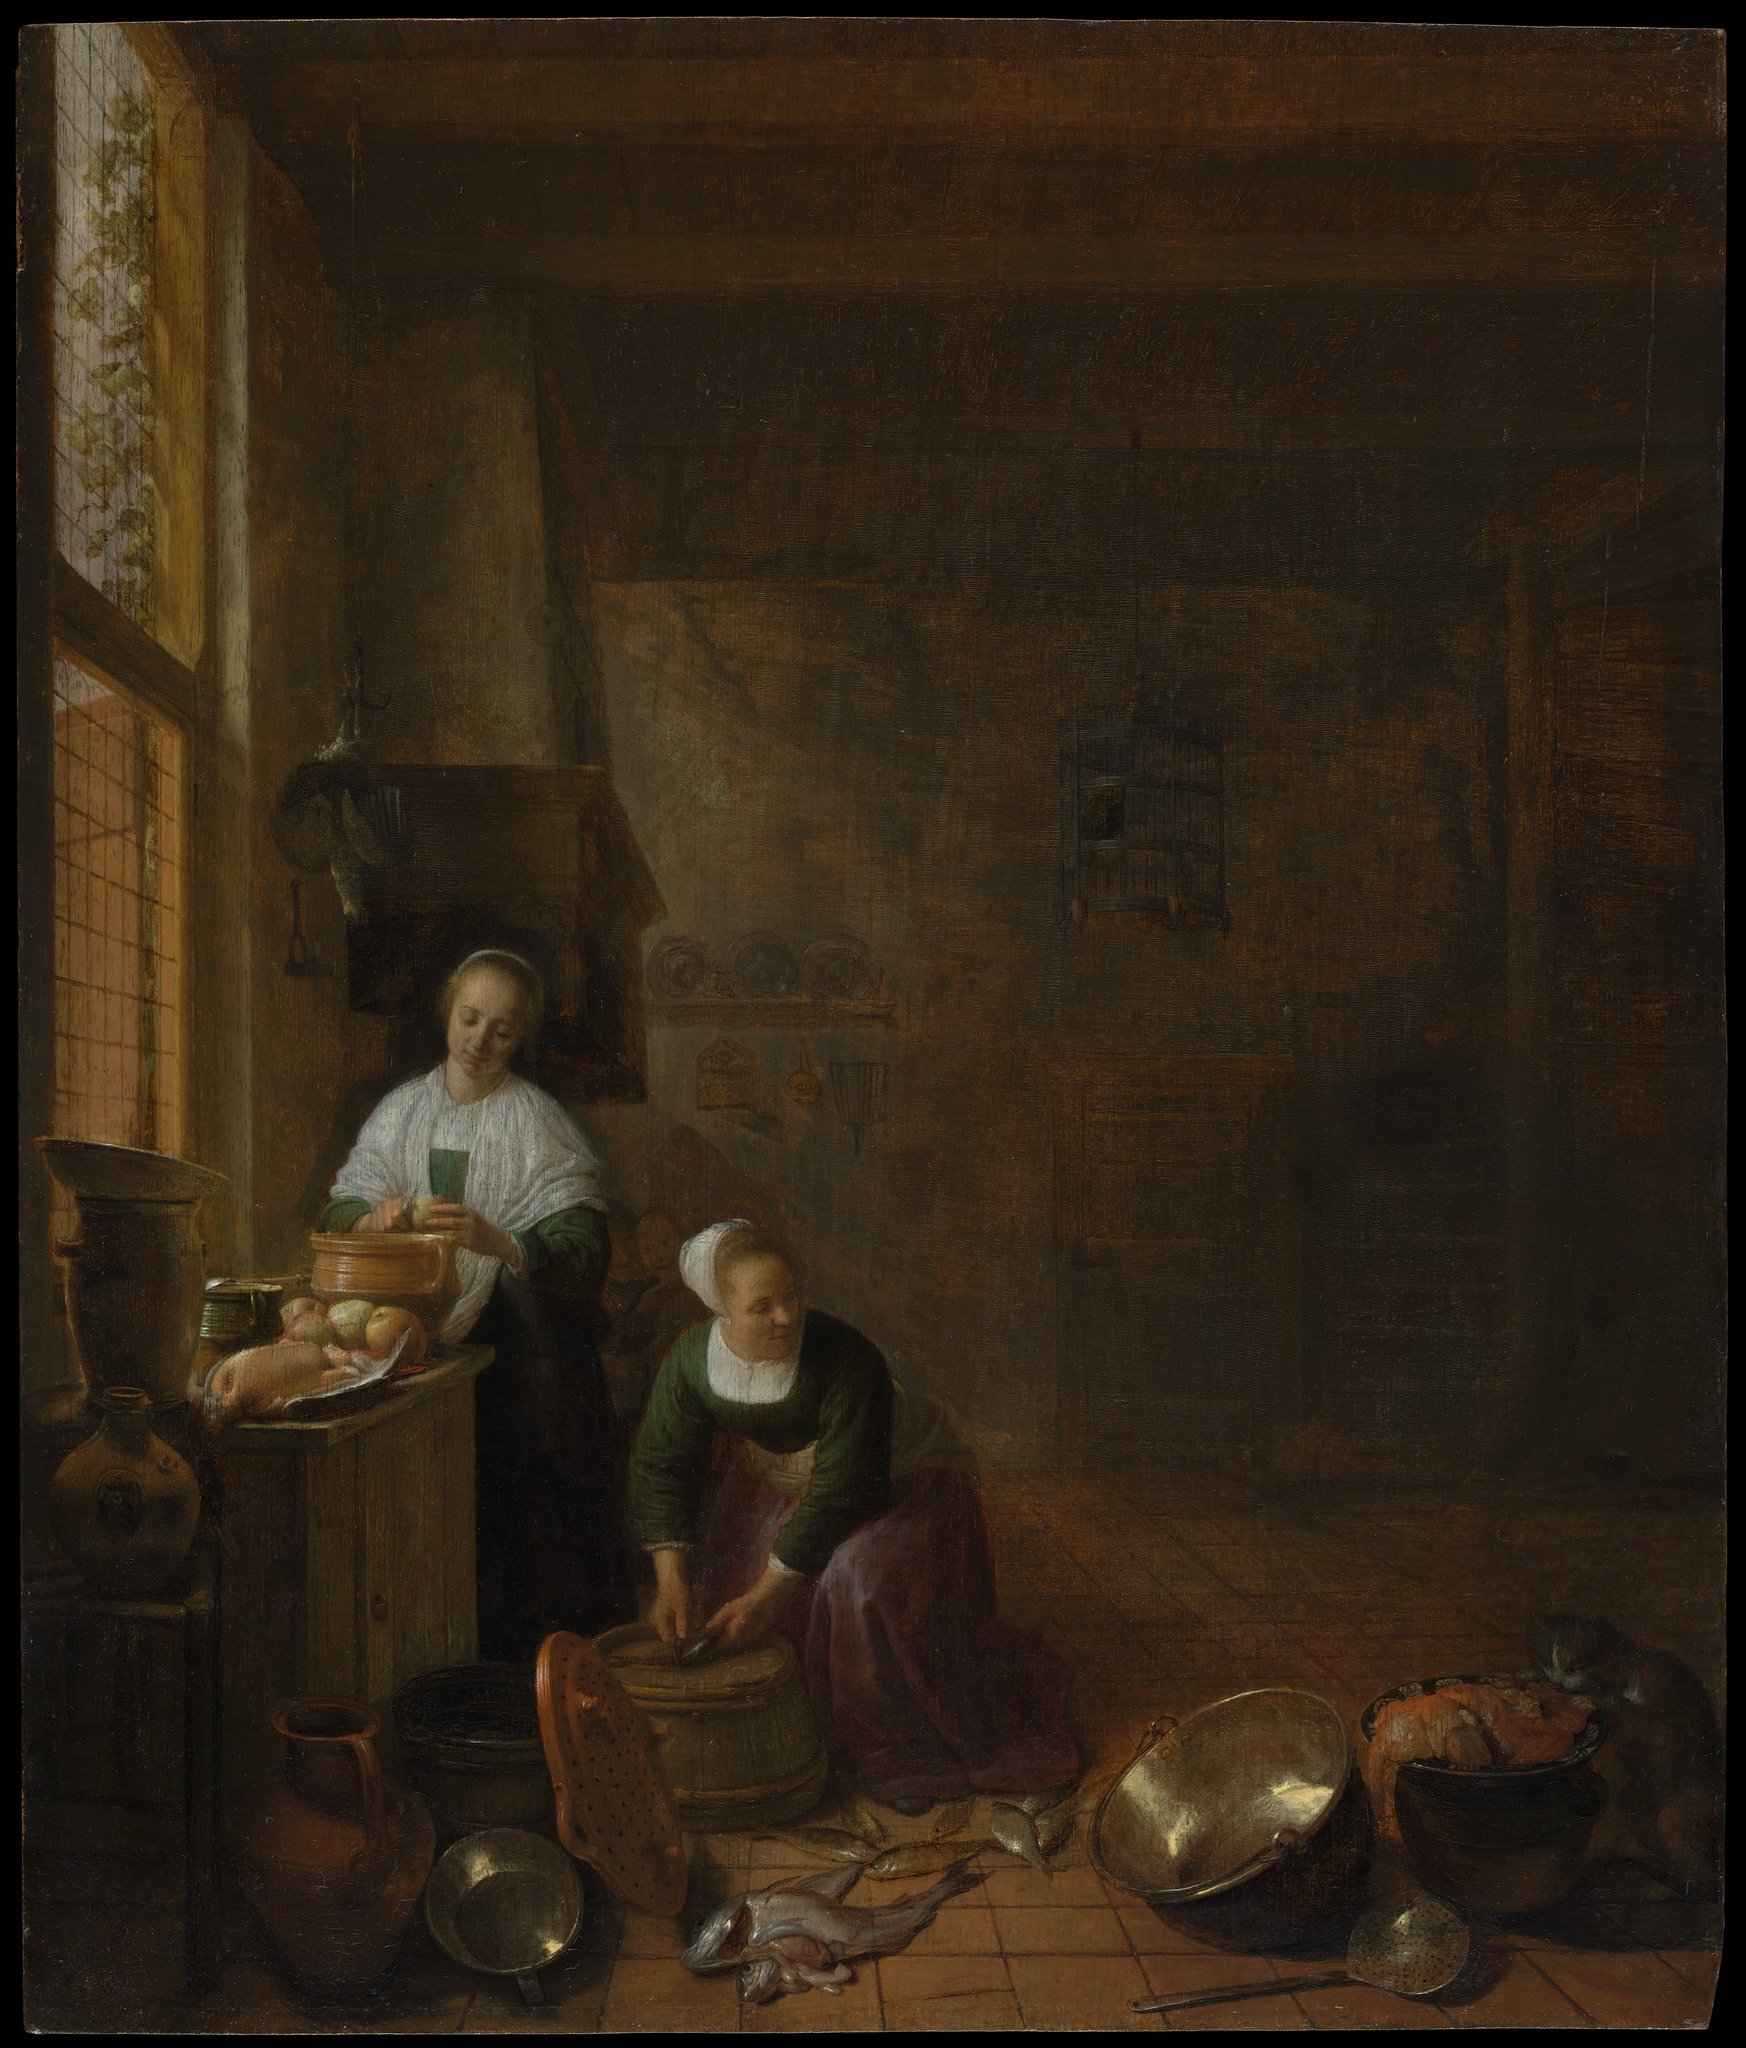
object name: painting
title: A Kitchen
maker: hendrick martensz. sorgh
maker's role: artist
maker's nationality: dutch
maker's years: 1609-1670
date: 1643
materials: oil, wood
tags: food,kitchens,women,cats,fish,servants,cooking